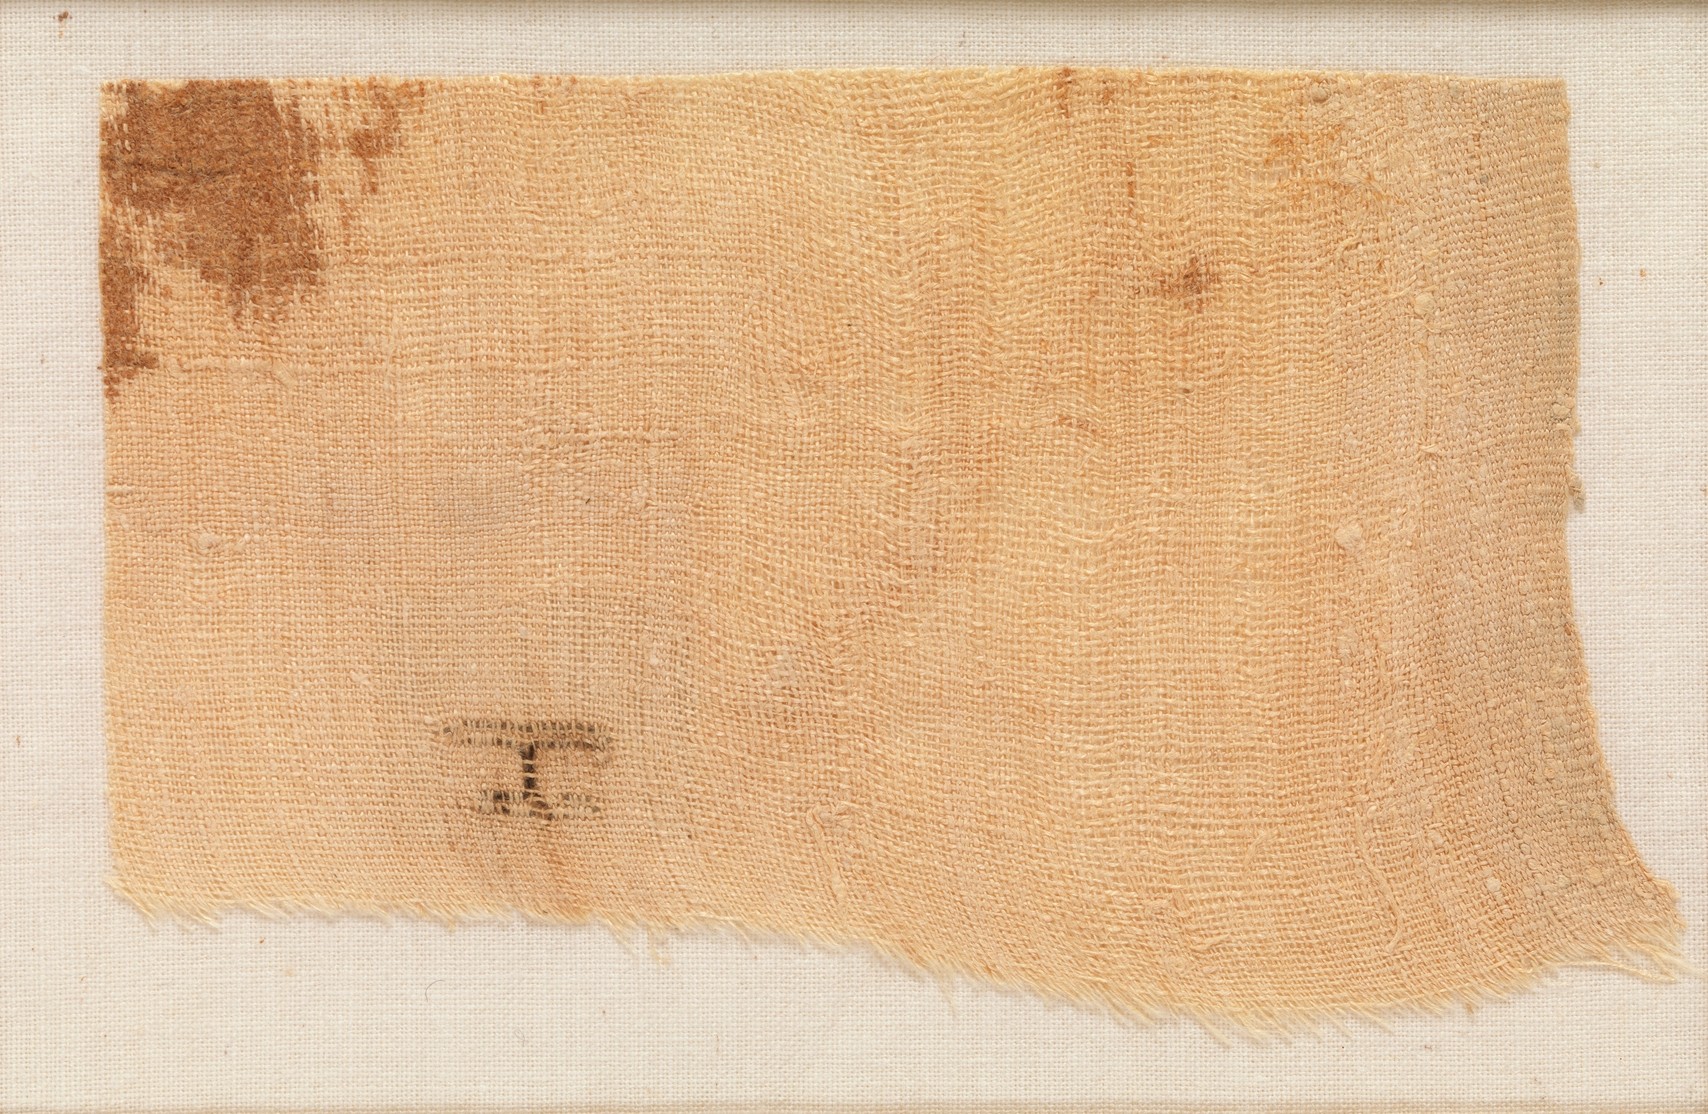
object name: linen mark, wah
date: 1981-1975 BCE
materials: linen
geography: egypt